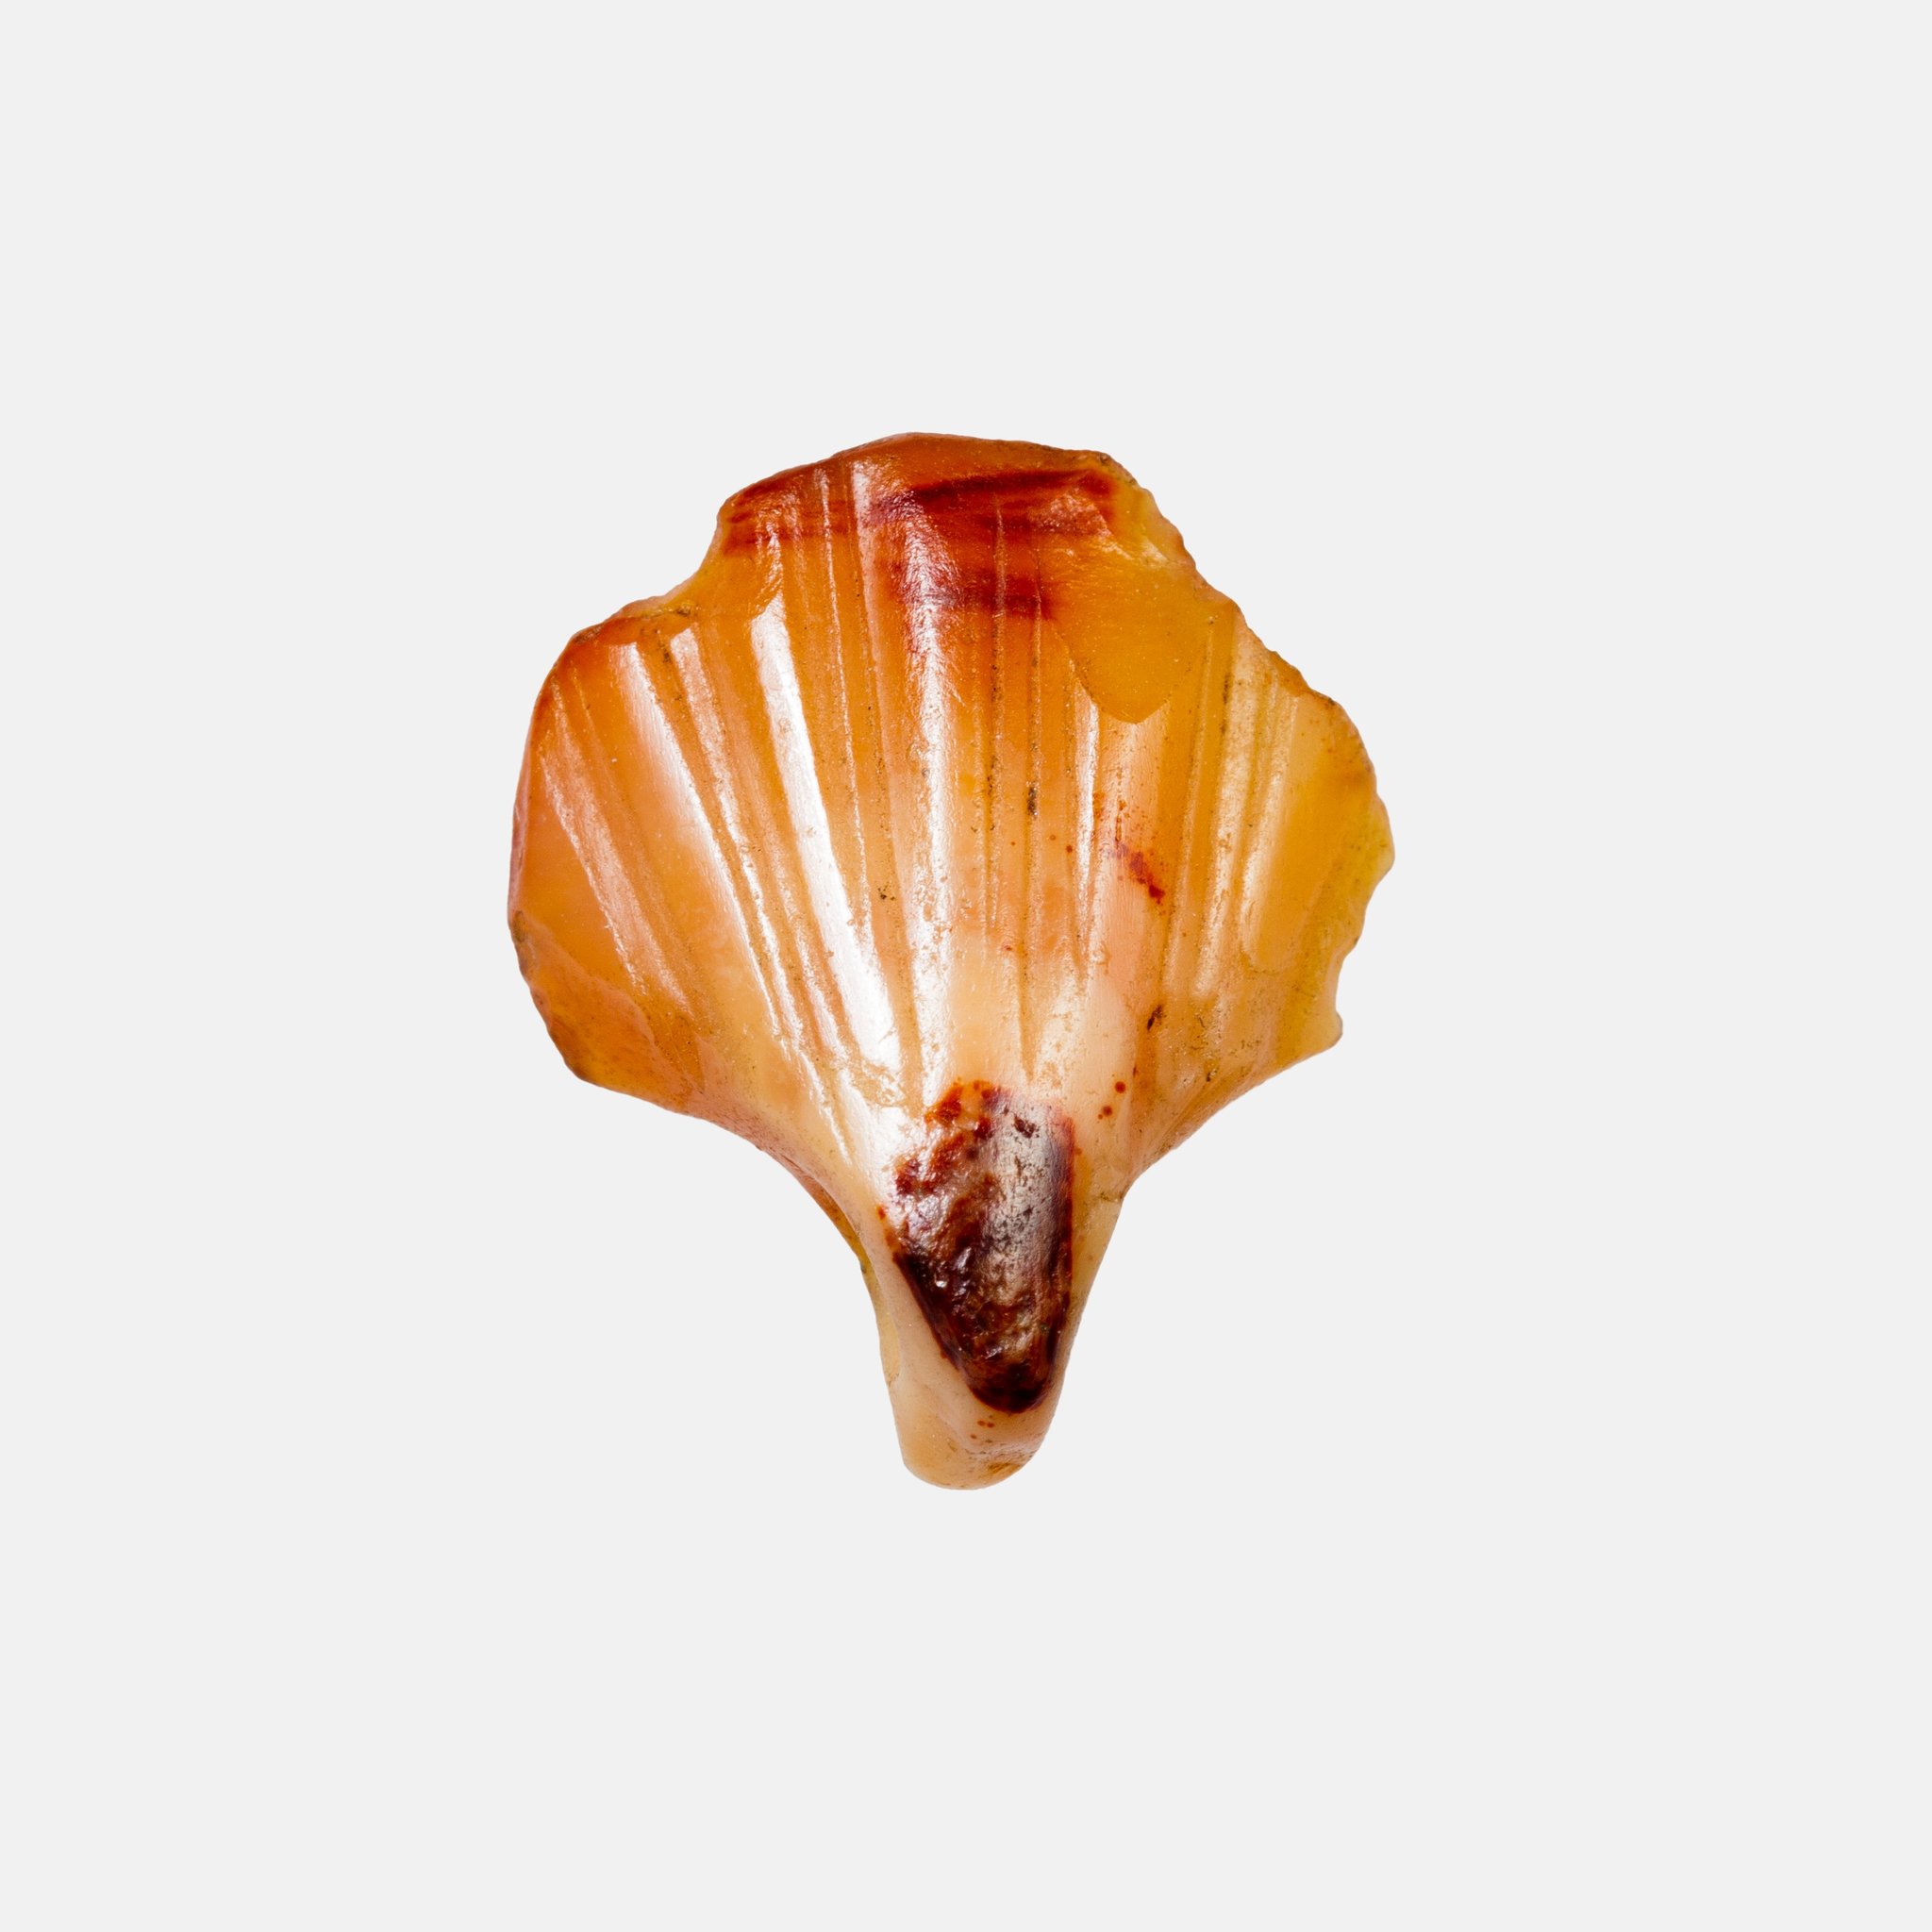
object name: amulet, shell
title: Shell Amulet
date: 2649-2100 BCE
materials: gemstone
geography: egypt